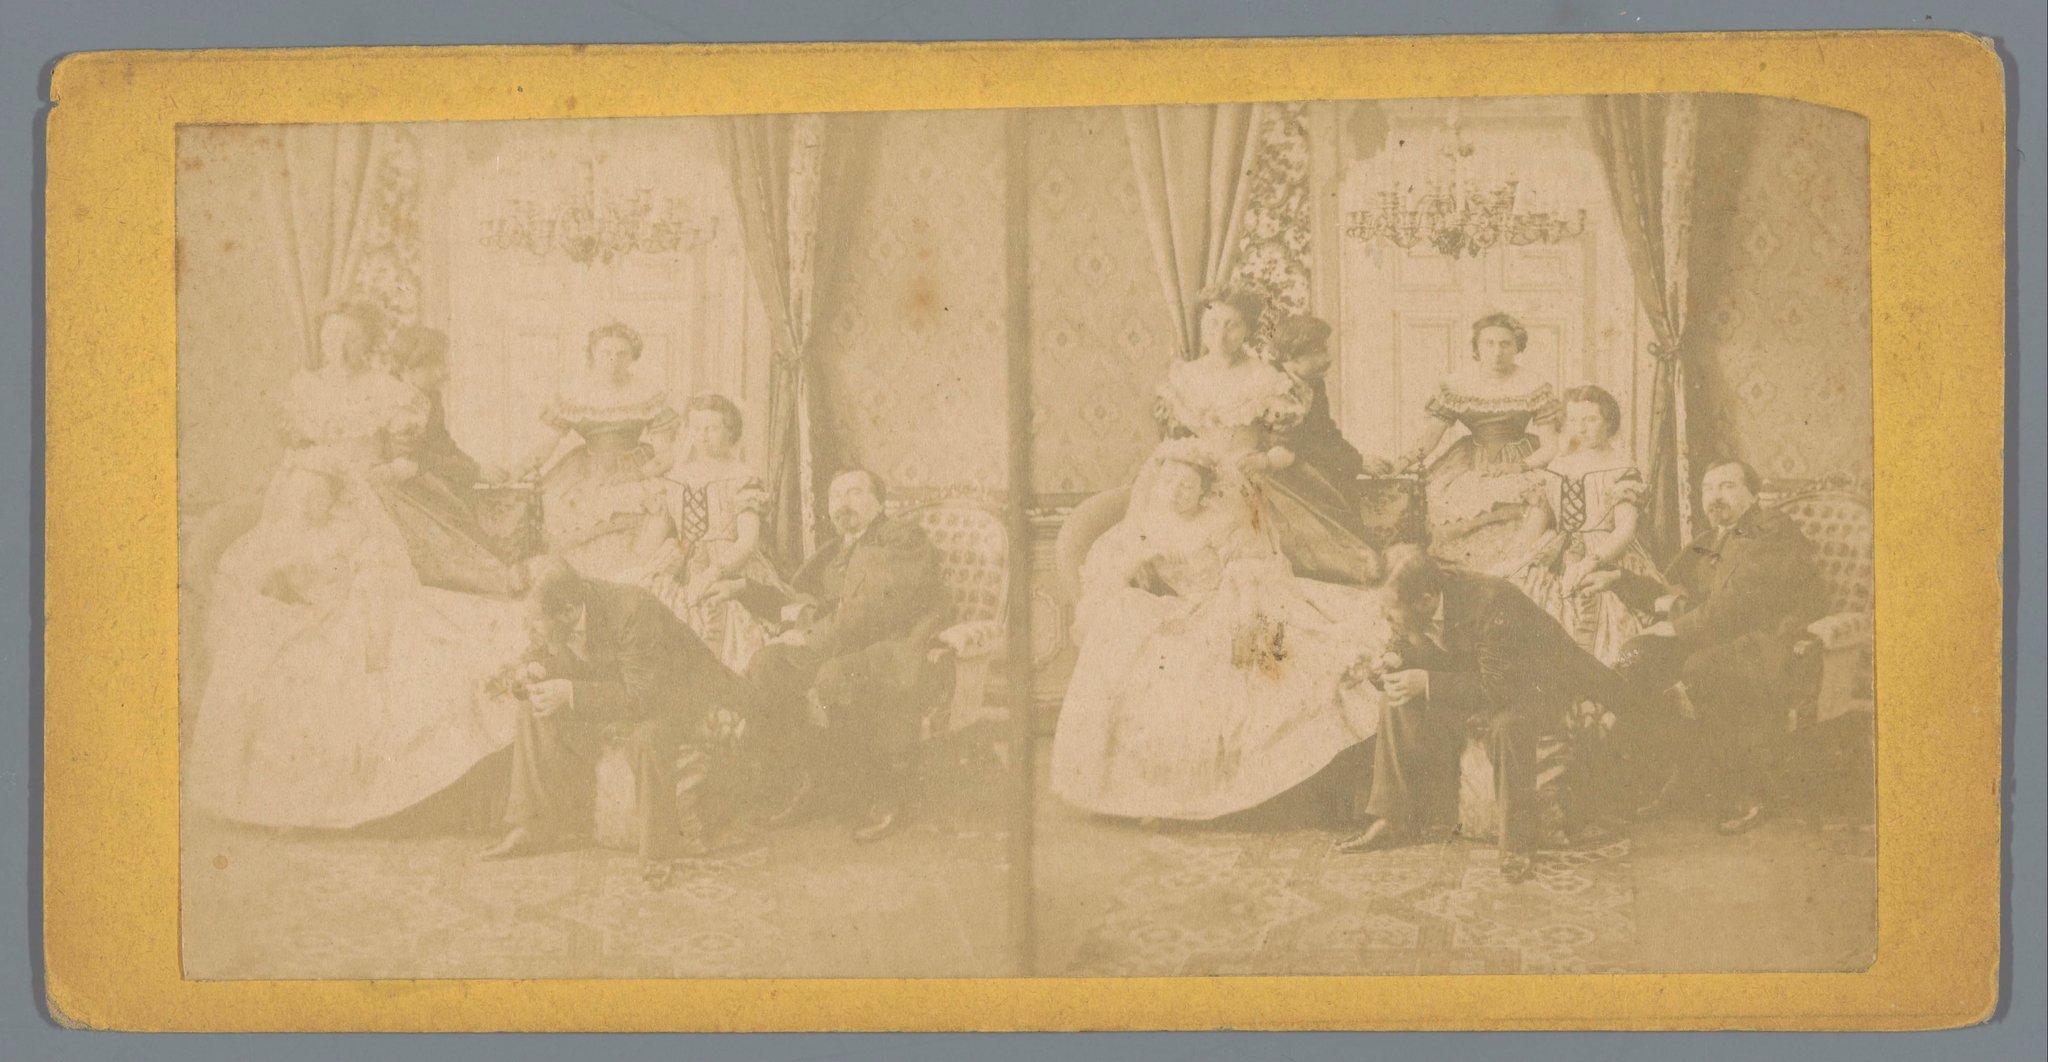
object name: stereograph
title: Bruidspaar met gevolg in een zitamer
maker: Anonymous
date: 1850-1880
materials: cardboard, photographic support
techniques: albumen print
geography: europe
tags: bride and groom in wedding-dress, living-room, parlour, sitting-room, europe